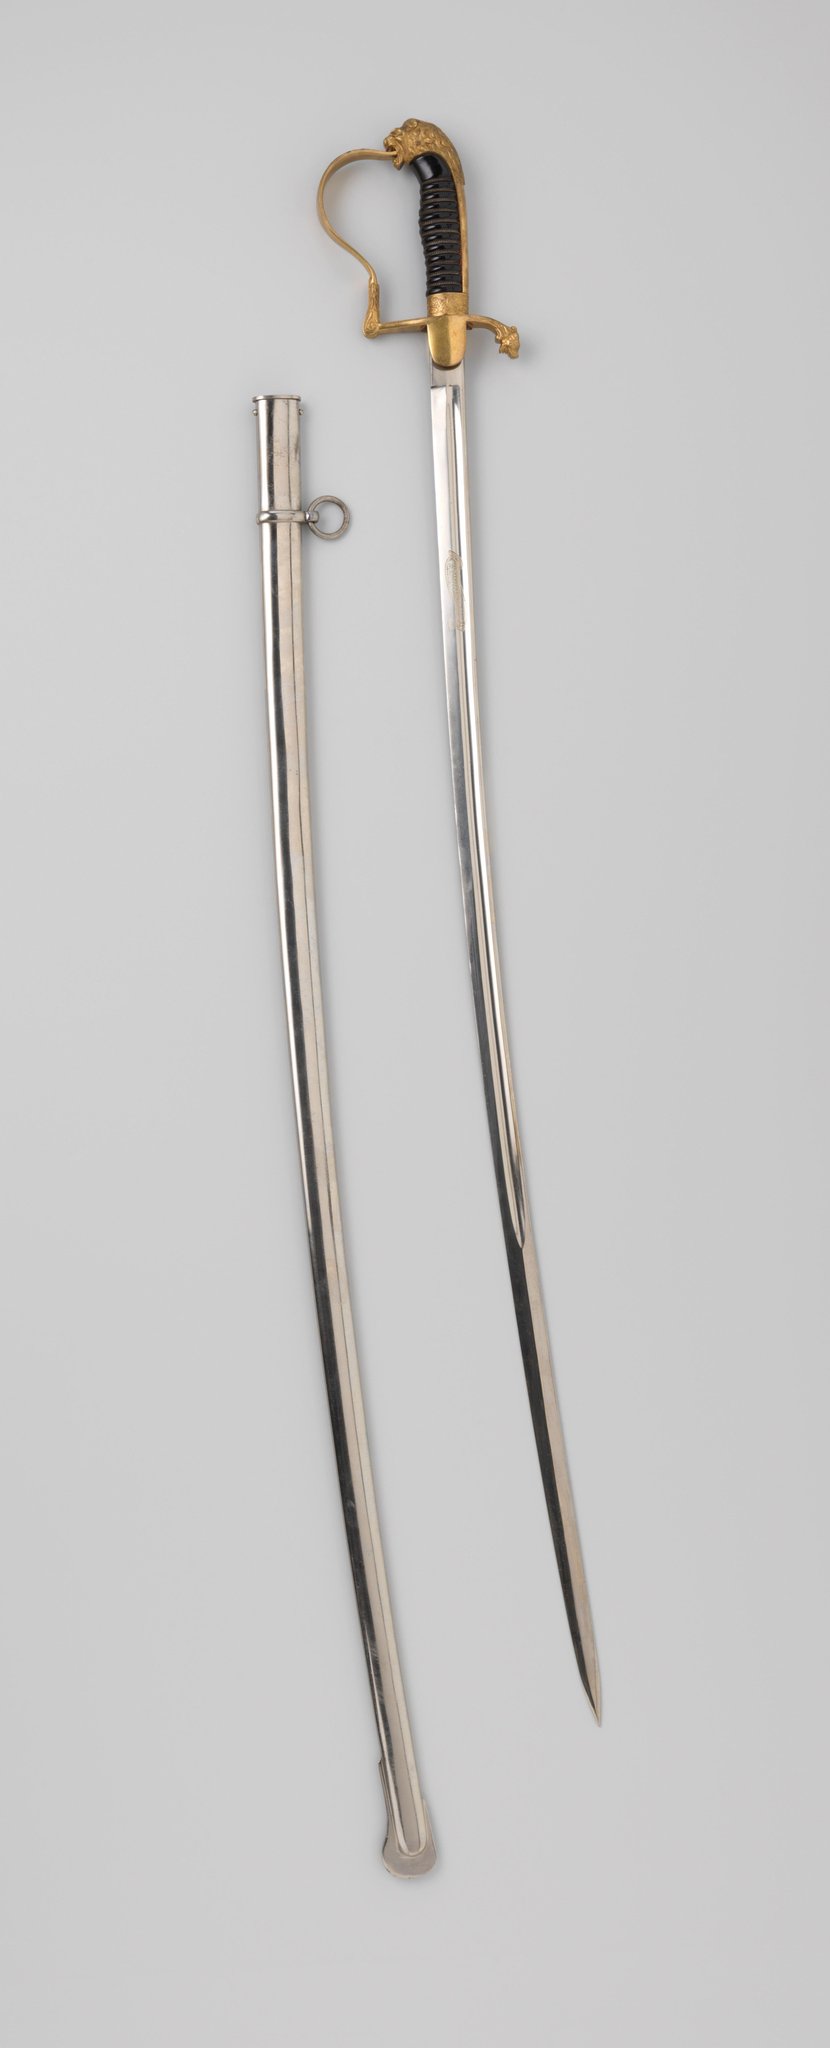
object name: small sword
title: Officierswandelsabel met schede M 1912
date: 1912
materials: chromium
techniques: gilding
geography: netherlands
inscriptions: signature: ‘E. & F. Hörster’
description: Officierswandelsabel M 1912. Verchroomde sierdegen, zwart met verguld heft; op degen opschrift: 'IJzerhouwer'. Bij de degen hoort een degenhoesje. Gesigneerd E. & F. Hörster.